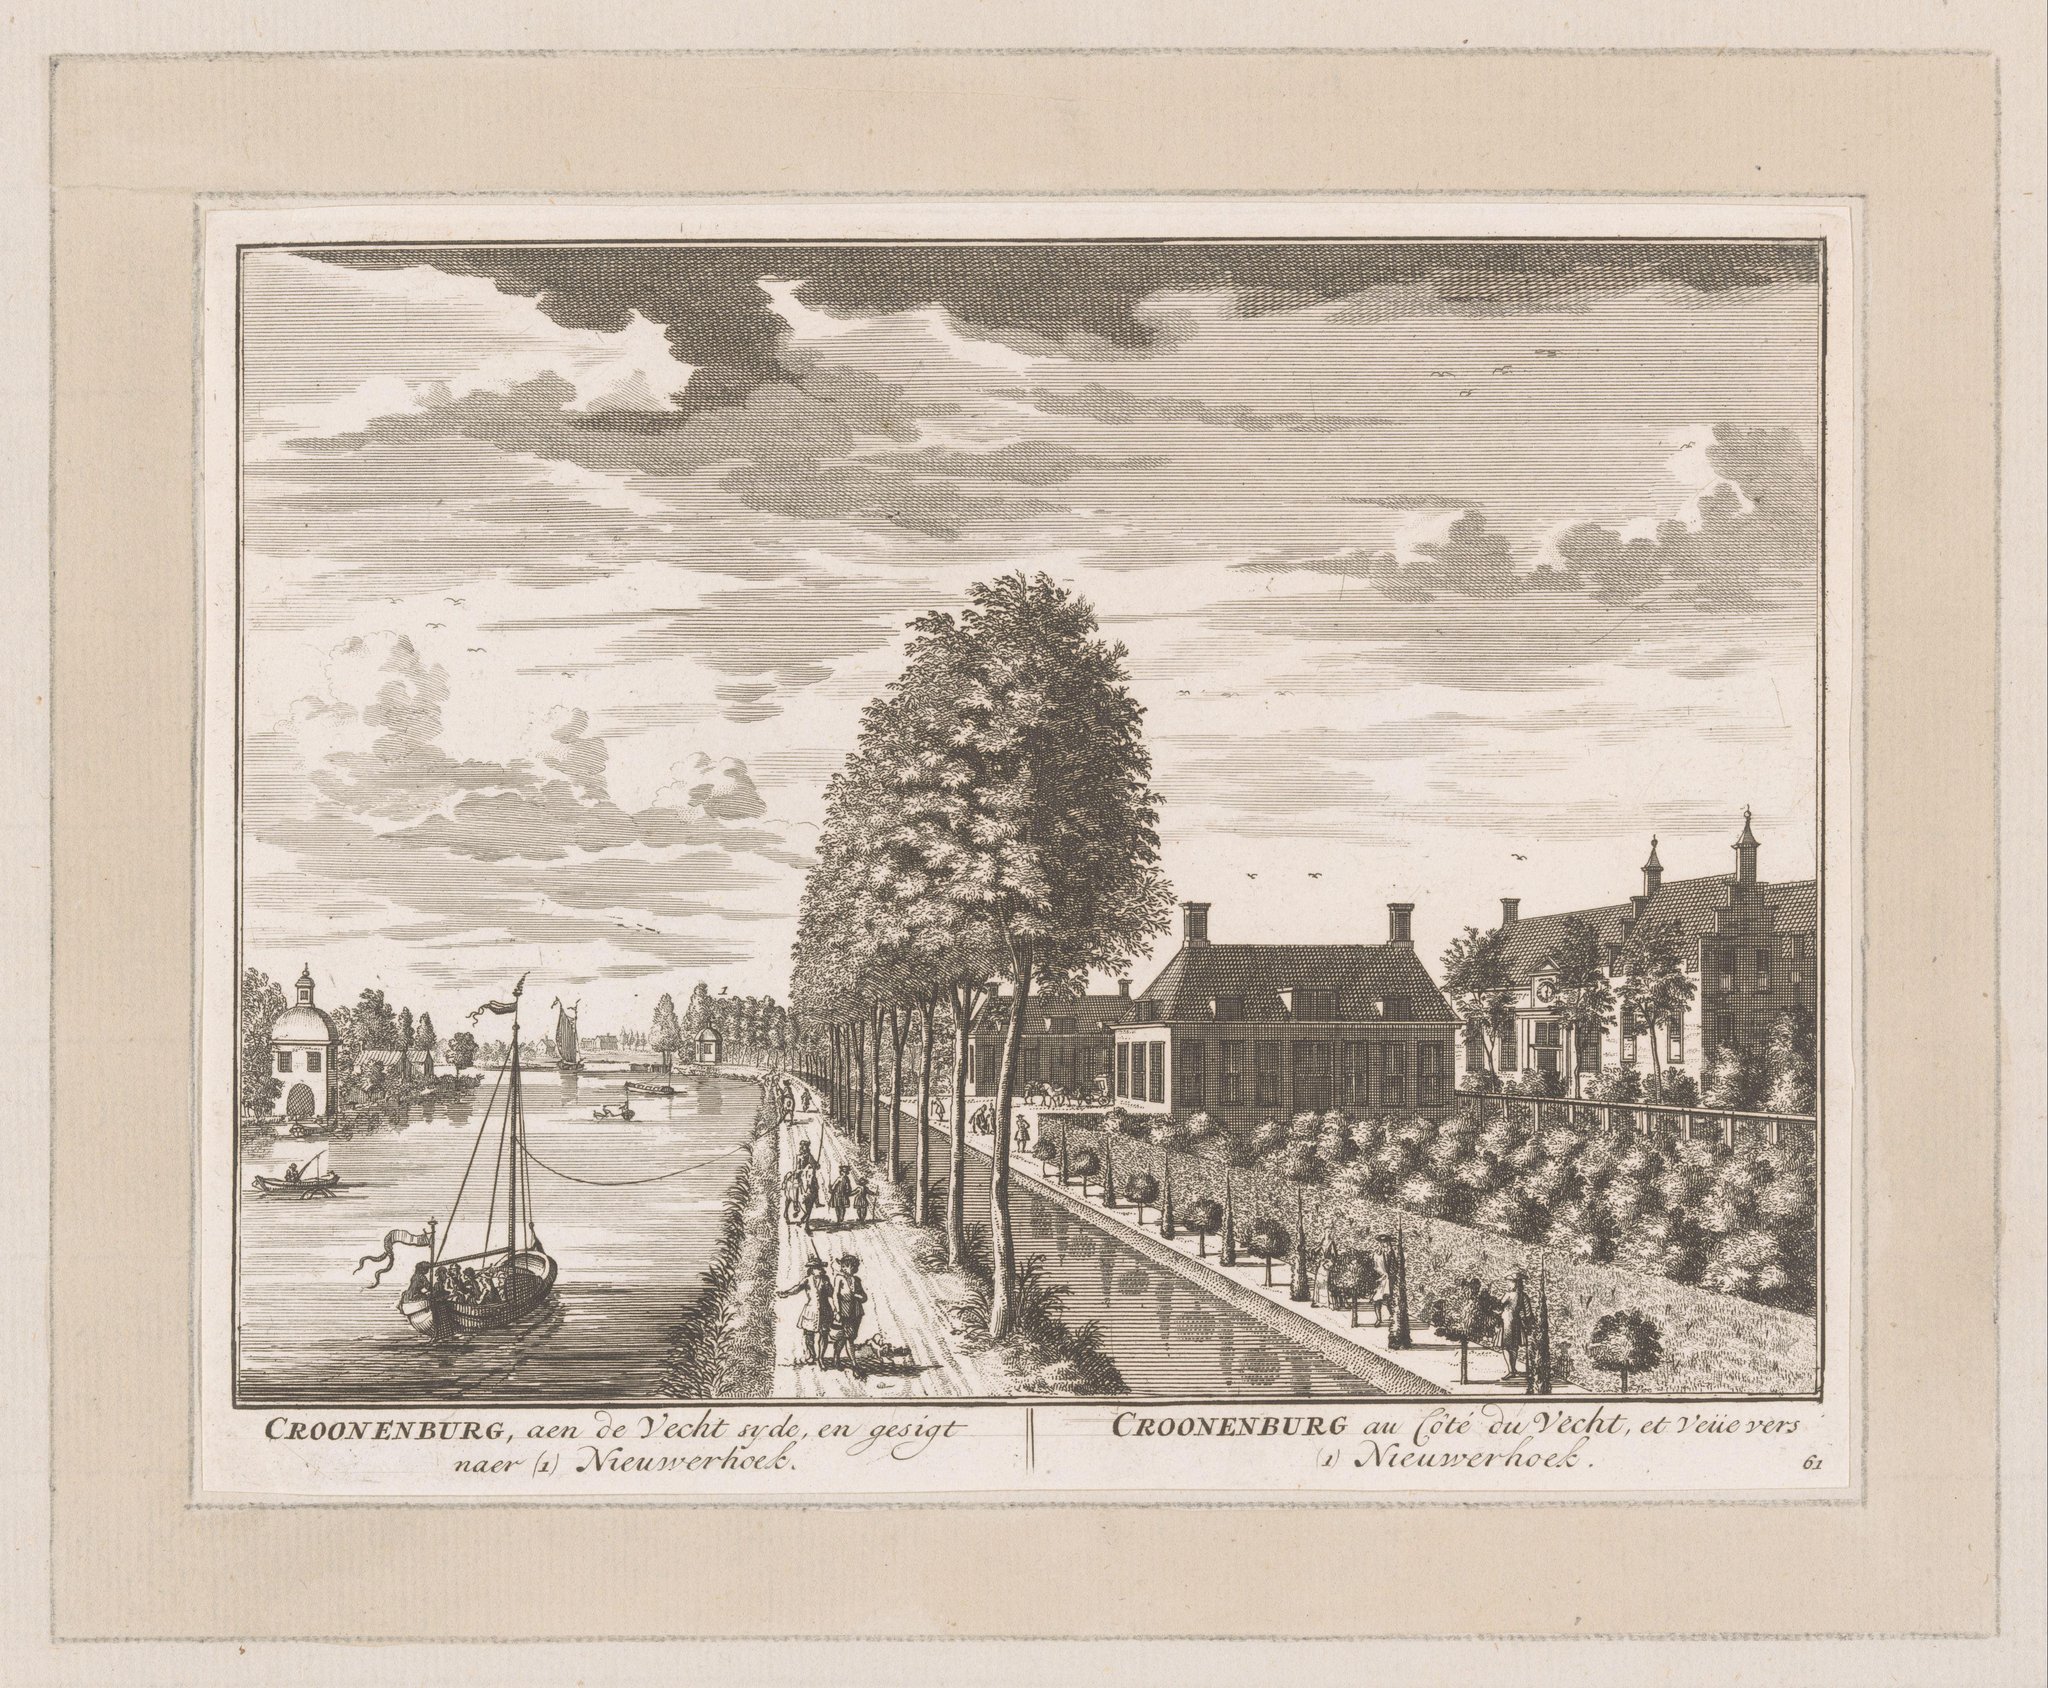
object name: print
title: Croonenburg, aen de Vecht syde, en gesigt naer (1) Nieuwerhoek / Croonenburg au Côté du Vecht, et Veüe vers (1) Nieuwerhoek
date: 1719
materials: paper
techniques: etching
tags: river, rural housing, e.g. country-house, villa, cottage, vecht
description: Prent uit: De zegepraalende Vecht, vertoonende verscheidene gesichten van lustplaatsen, heeren huysen en dorpen, beginnende van Uitrecht en met Muyden besluytende. Amsterdam: Wed. Nicolaes Visscher, 1719.